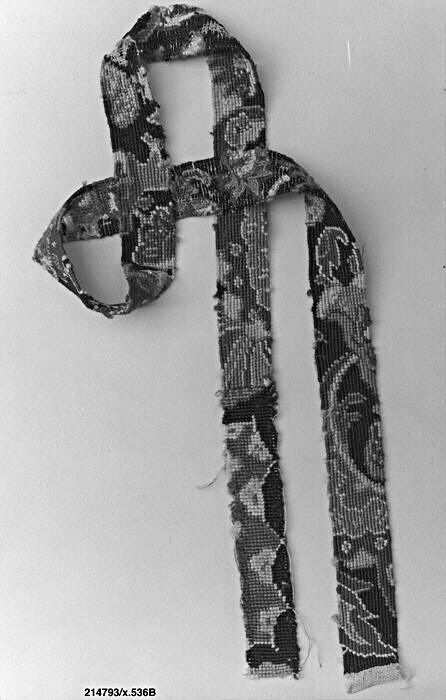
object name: strip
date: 1701-1733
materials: linen, wool